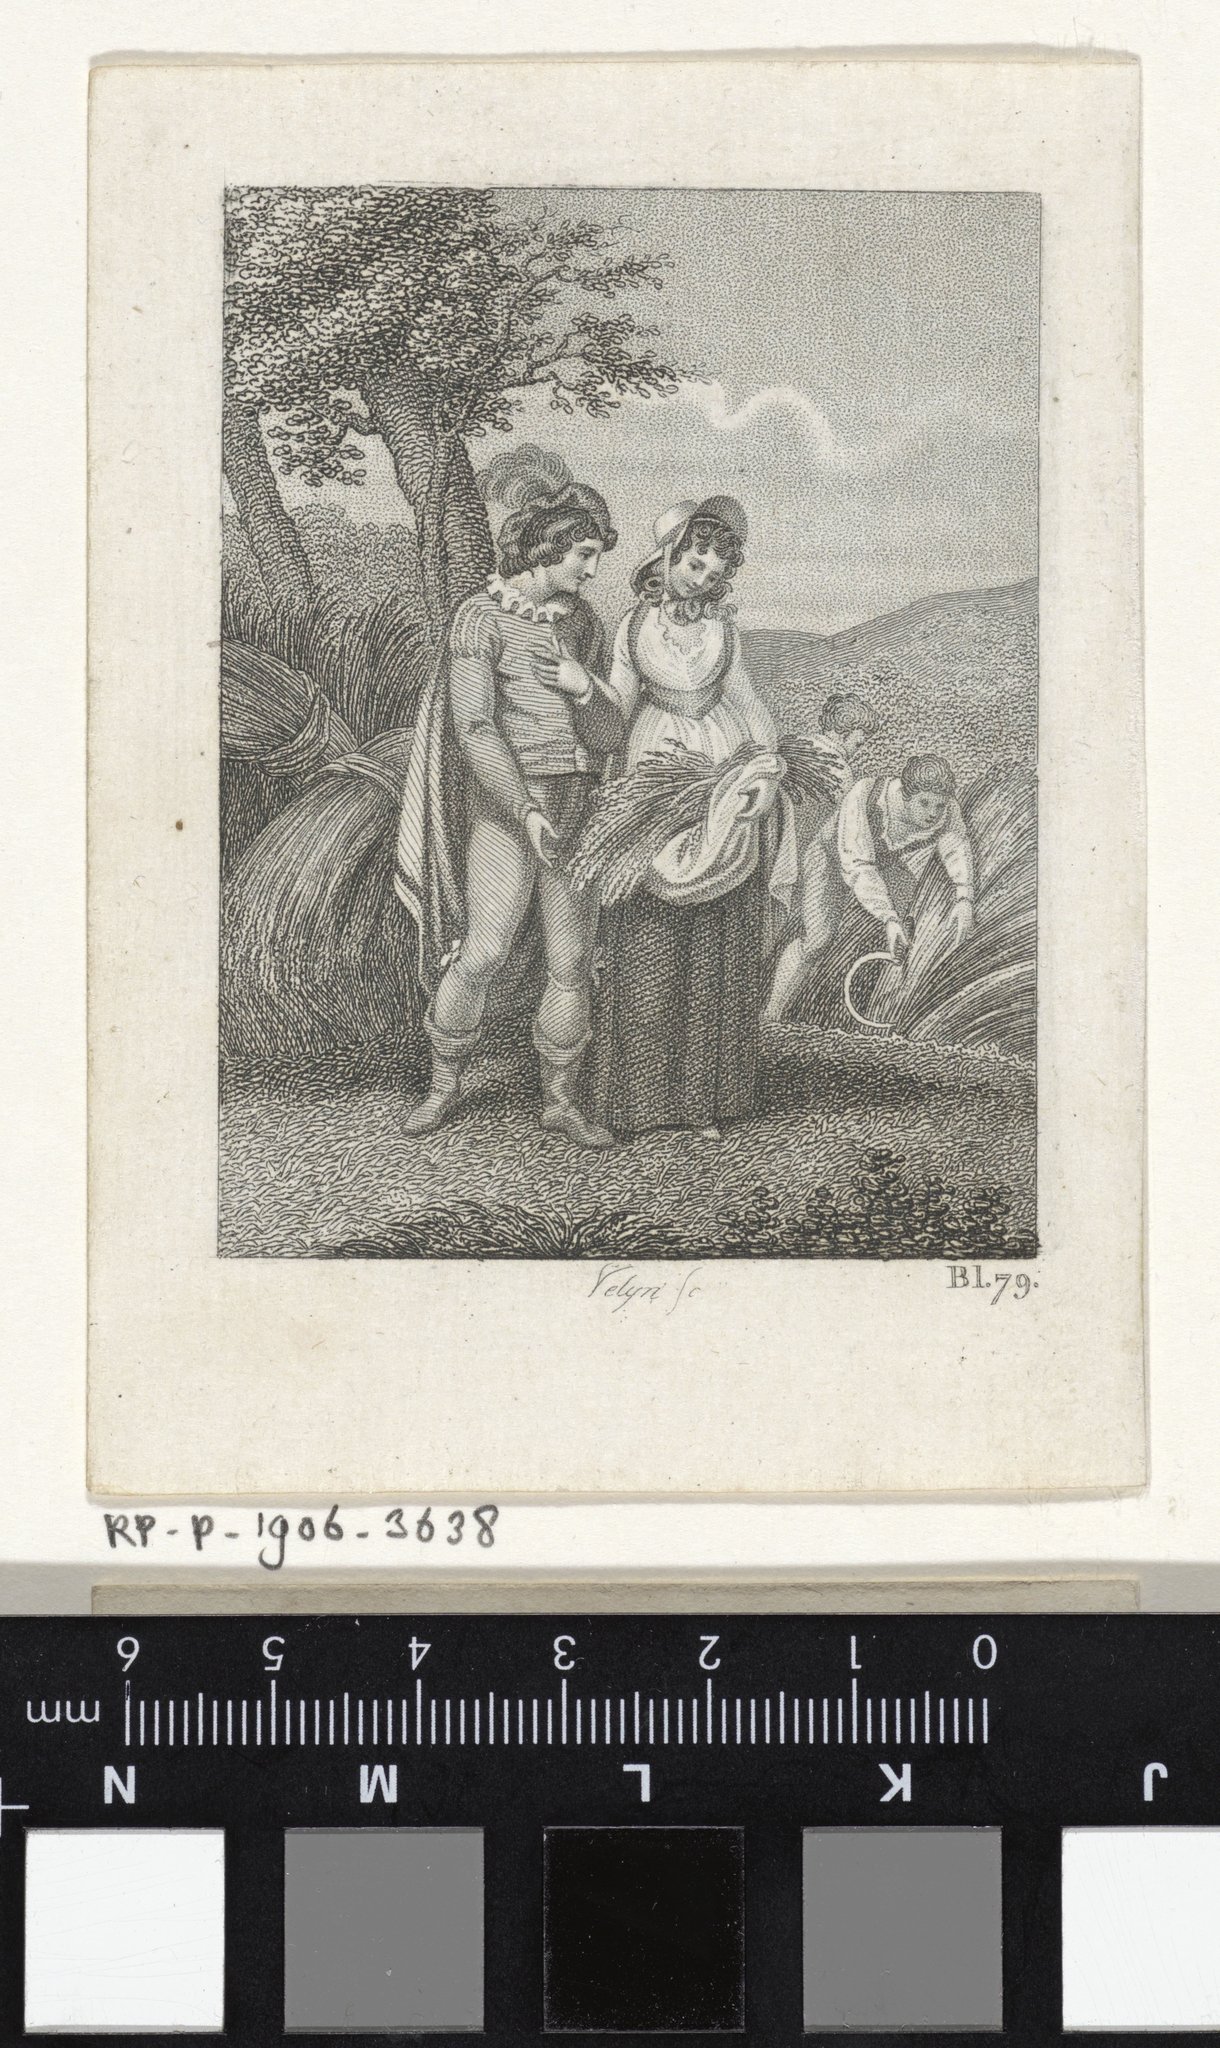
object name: book illustration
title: Paar bij maaiers en korenschoven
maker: philippus velijn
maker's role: print maker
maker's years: 1787-1836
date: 1820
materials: paper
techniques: etching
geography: netherlands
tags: youth, adolescent, binding ~ harvest, reaping, picking, mowing ~ harvest, arm in arm (lovers)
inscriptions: collector's mark: Lugt 2228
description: Een man heeft de hand van de vrouw die naast hem staat tegen zijn borst gedrukt. De vrouw heeft een korenschoof in haar schort. Op de achtergrond twee maaiers en links korenschoven. Rechtsonder: bl.73.